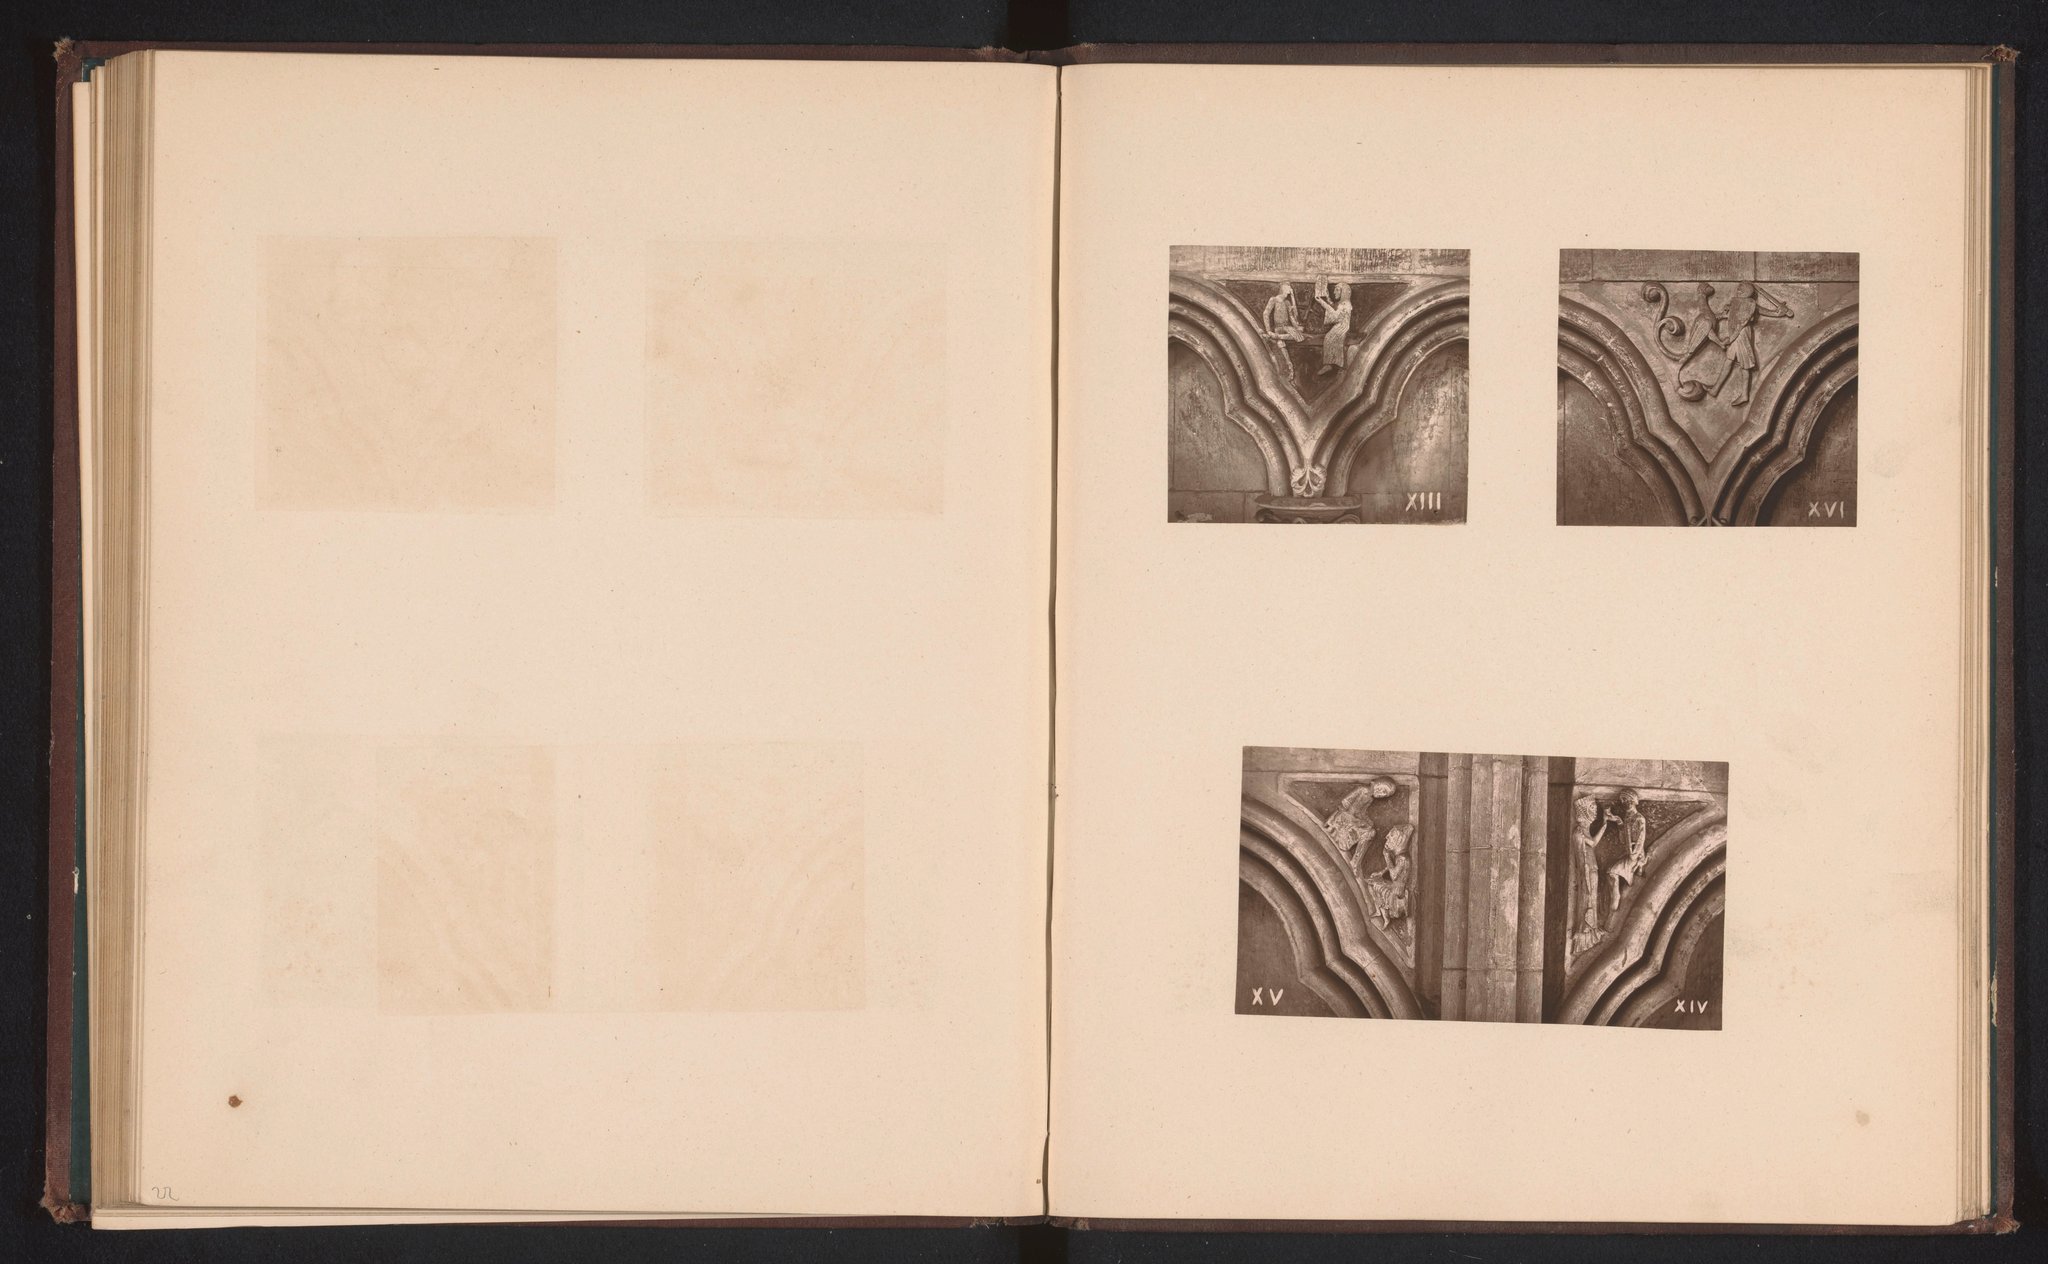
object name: page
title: Drie houtsnijwerken in een arcade van de Kathedraal van Worcester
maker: Anonymous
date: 1863-1873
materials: paper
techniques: woodburytype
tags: architect offering design or model to patron, carving ~ applied arts, interior of church, man struggling with animals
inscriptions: number: ‘XIII (...) XVI’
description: Linksboven een architect toont zijn plannen aan een figuur, rechtsboven een figuur in gevecht met een fabelwezen, onder een monnik beoefent een ambacht en een beeldhouwer toont een sculptuur.